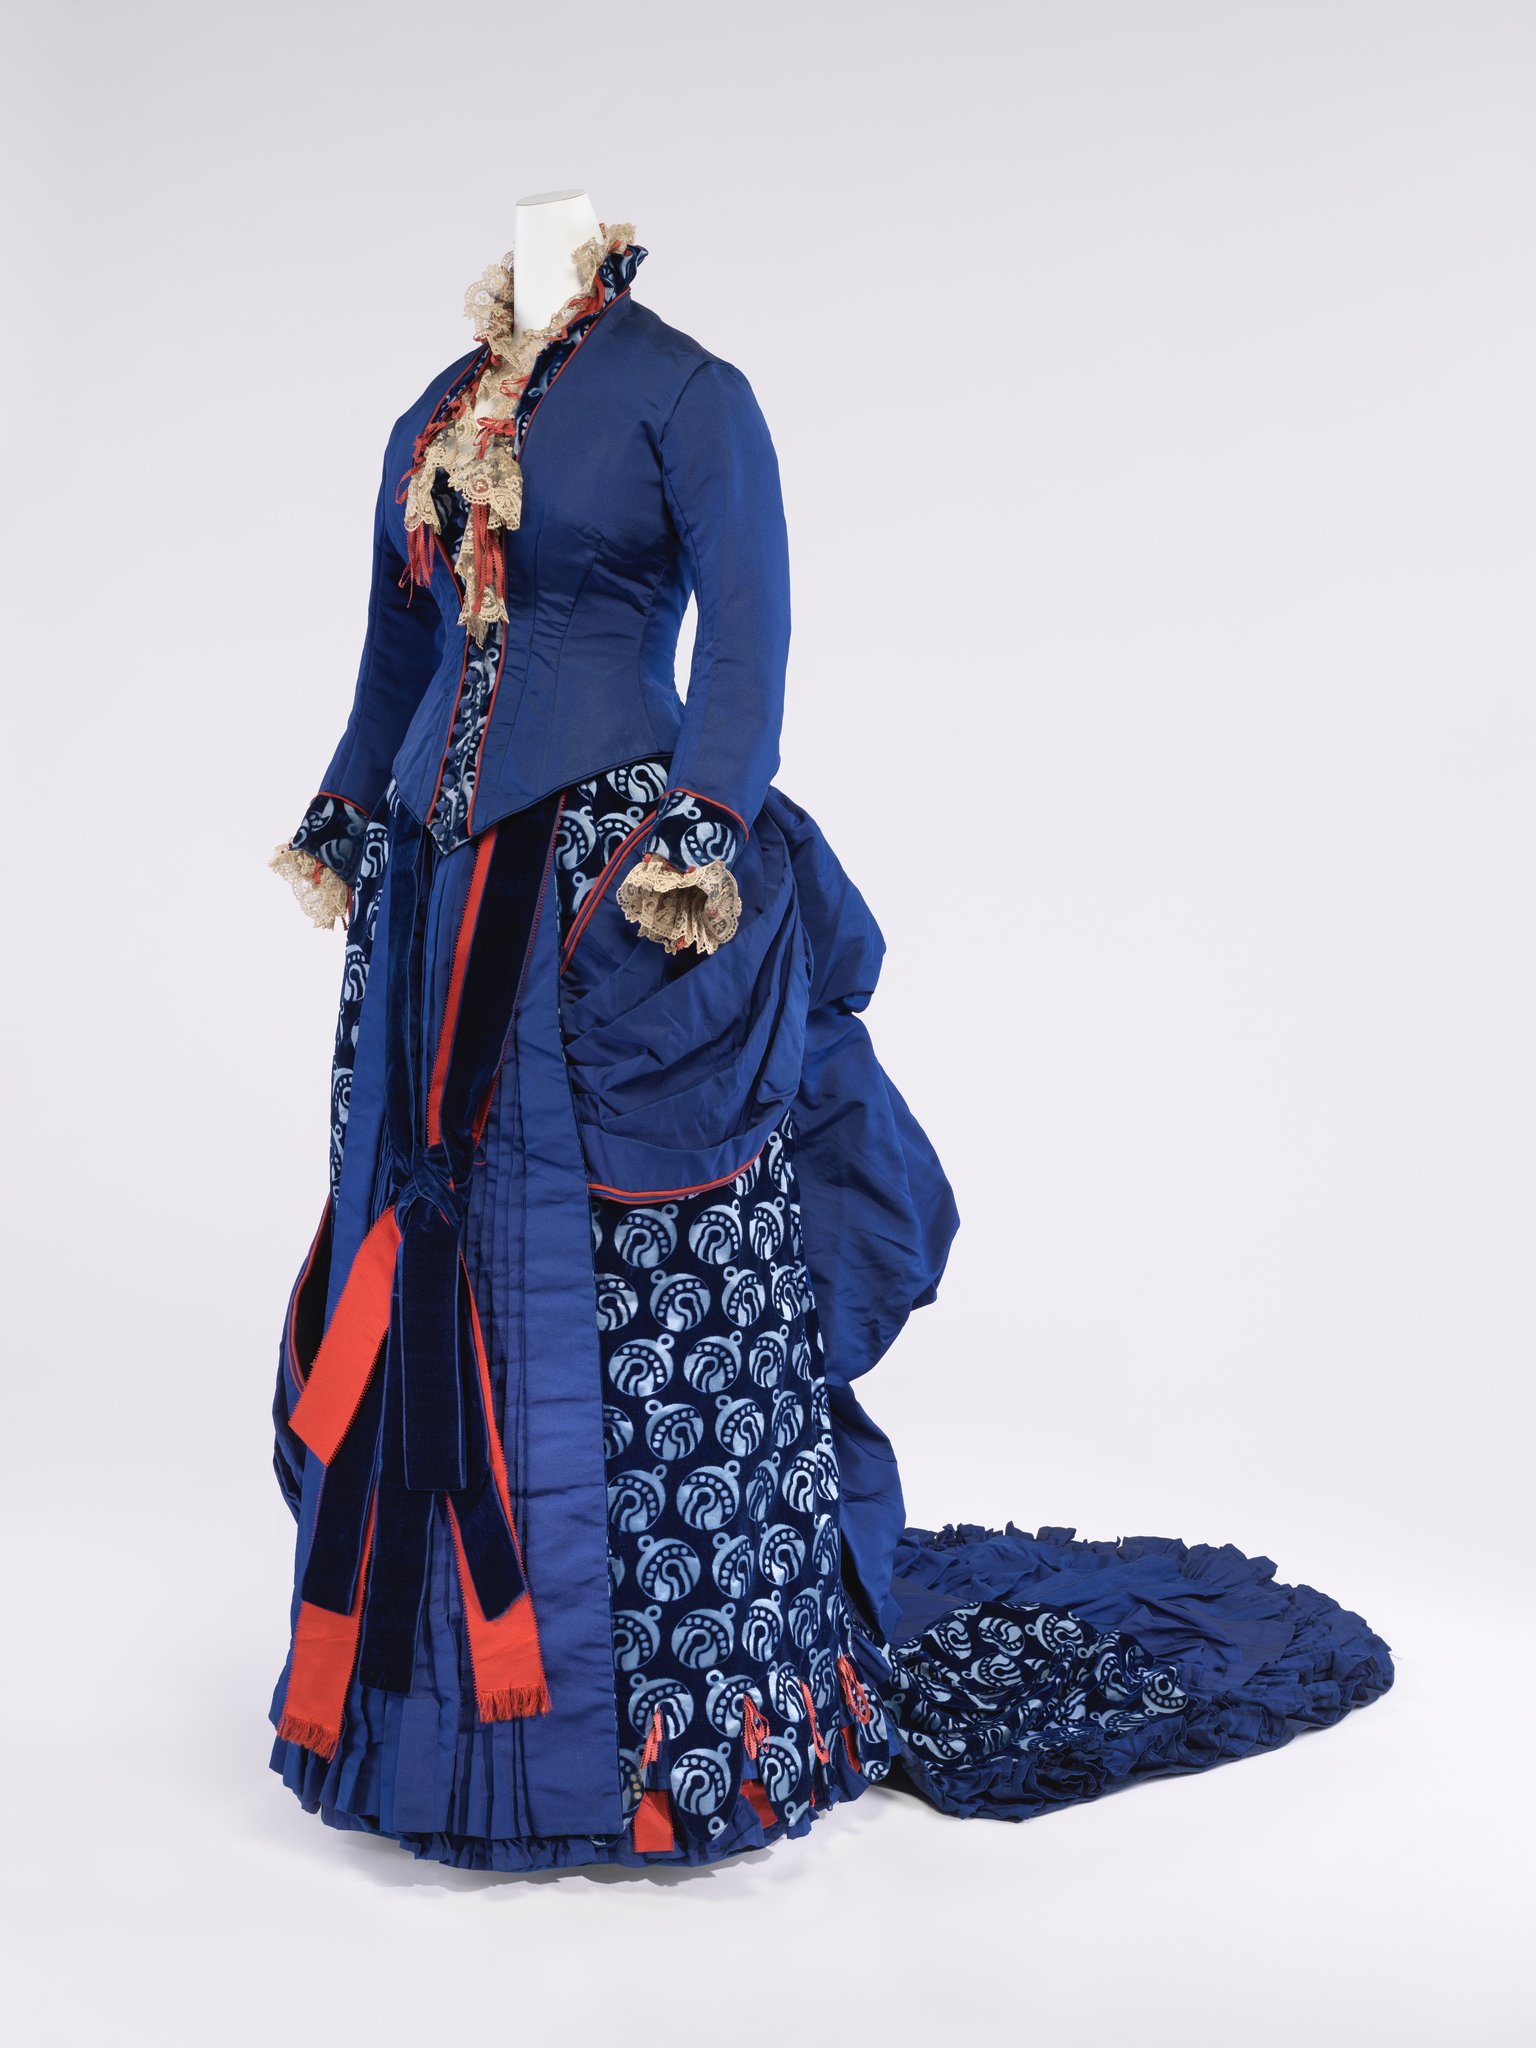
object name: dress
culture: american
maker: darlington, runk & co.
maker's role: department store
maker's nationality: american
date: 1880-1885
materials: silk